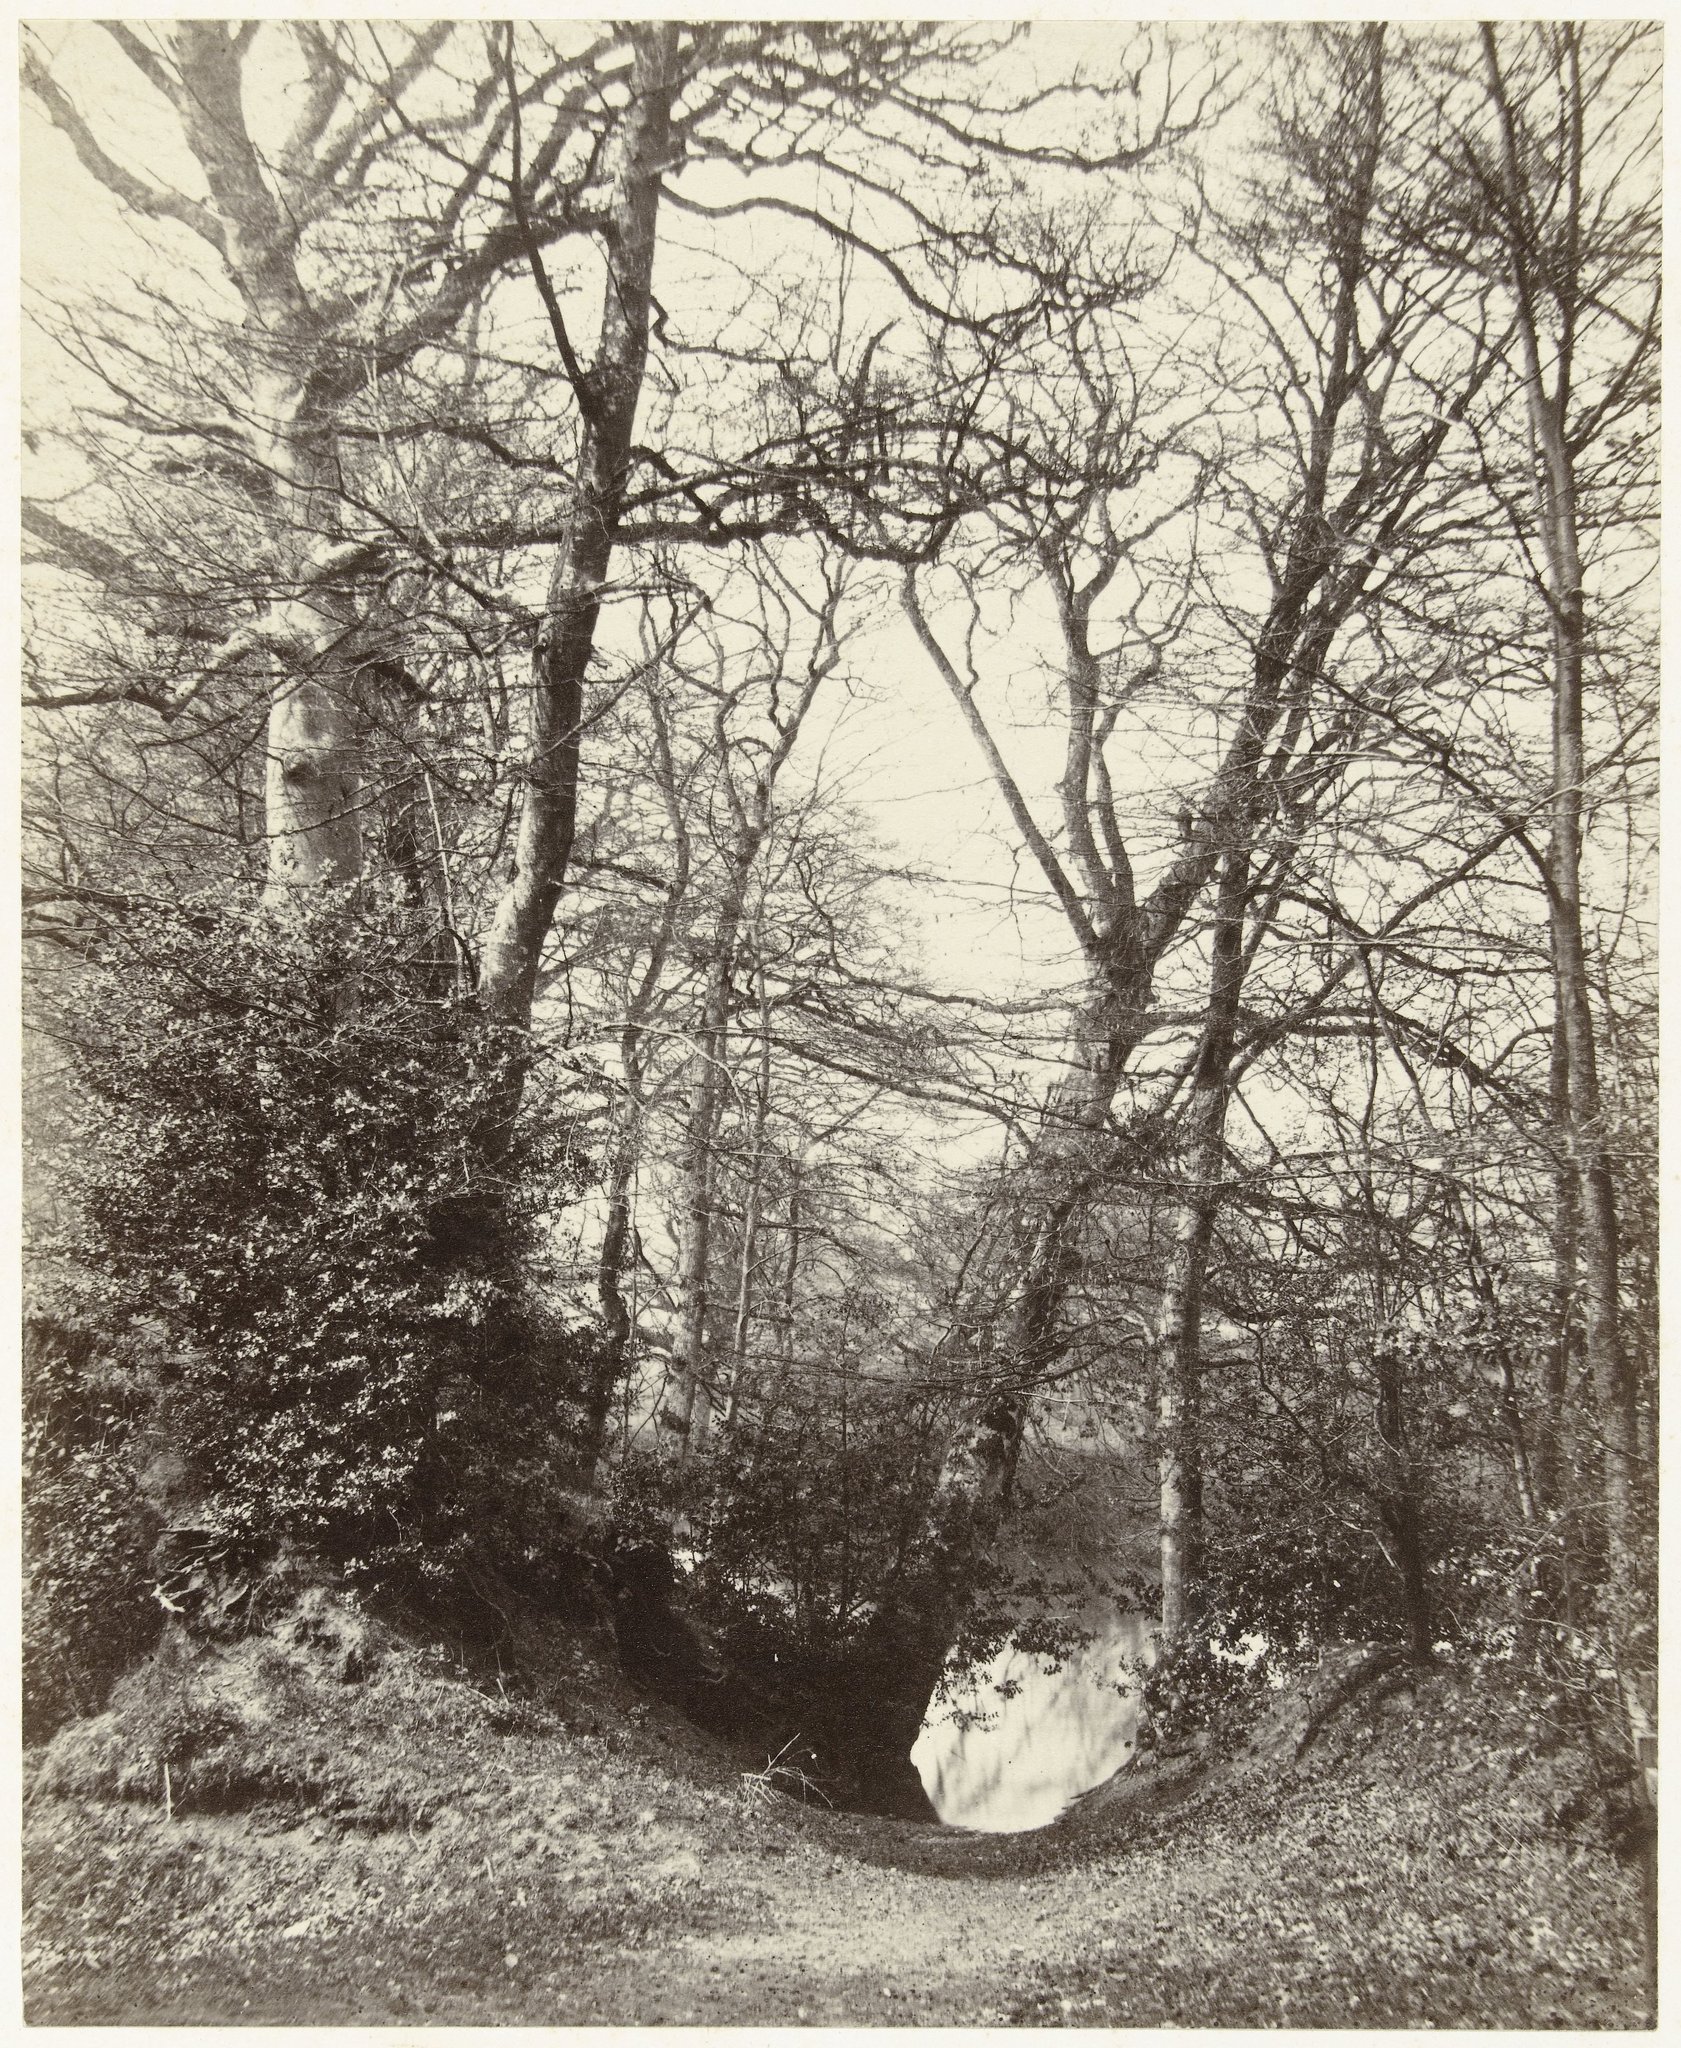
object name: photograph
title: Prep on the Mole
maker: alfred rosling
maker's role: fotograaf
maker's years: 1802-1882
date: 1855-1882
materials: cardboard, paper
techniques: albumen print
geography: great britain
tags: forest path or lane, great britain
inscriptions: number: ‘63’